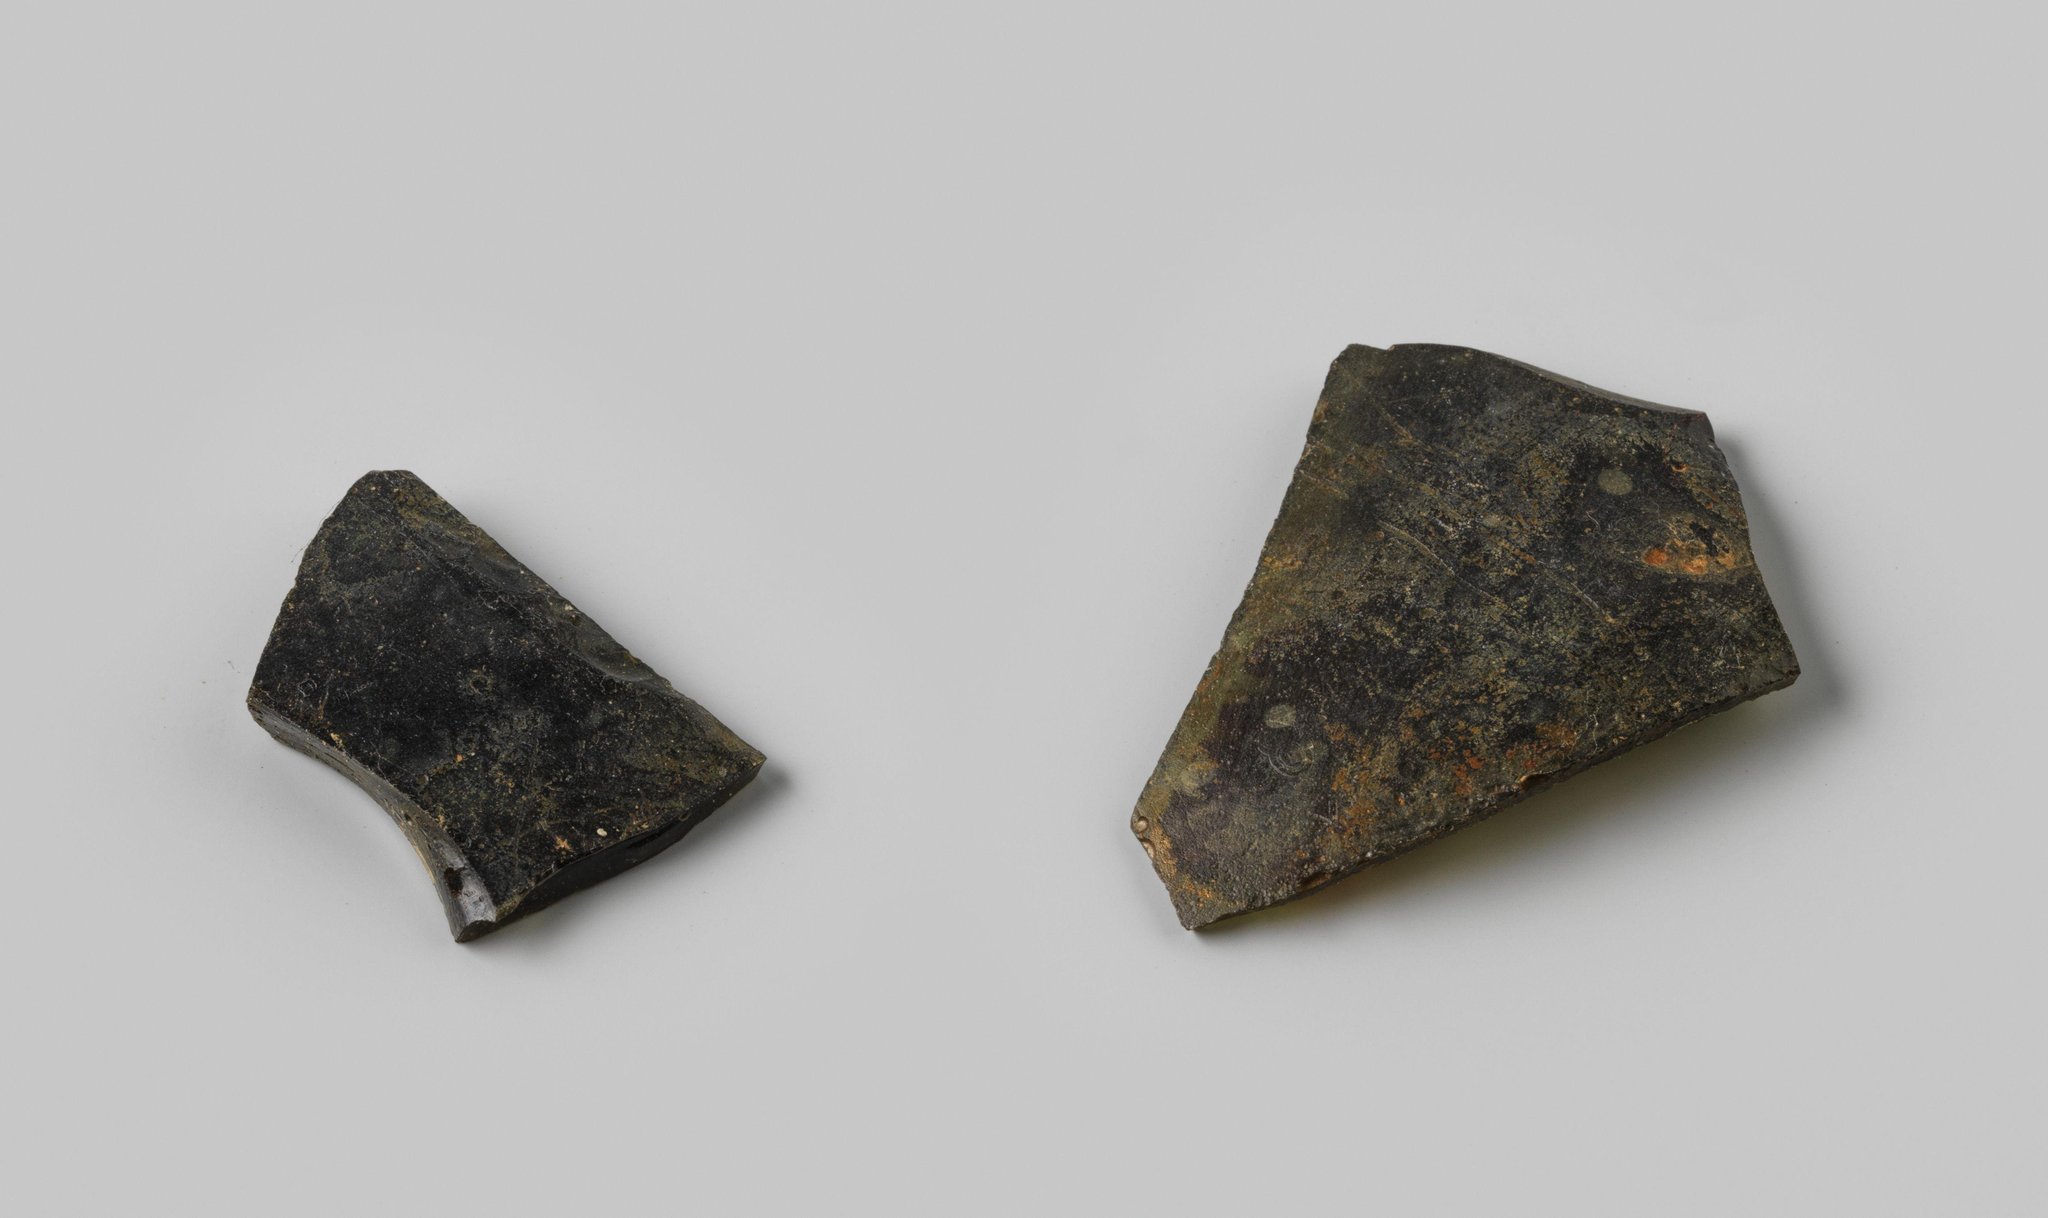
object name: wine bottle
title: Scherven van wijnflessen uit het wrak van de Oost-Indiëvaarder Hollandia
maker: Anonymous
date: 1700-1743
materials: glass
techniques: green glass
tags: verenigde oostindische compagnie, hollandia (schip)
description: Typologically not identifiable, belly, fragment.